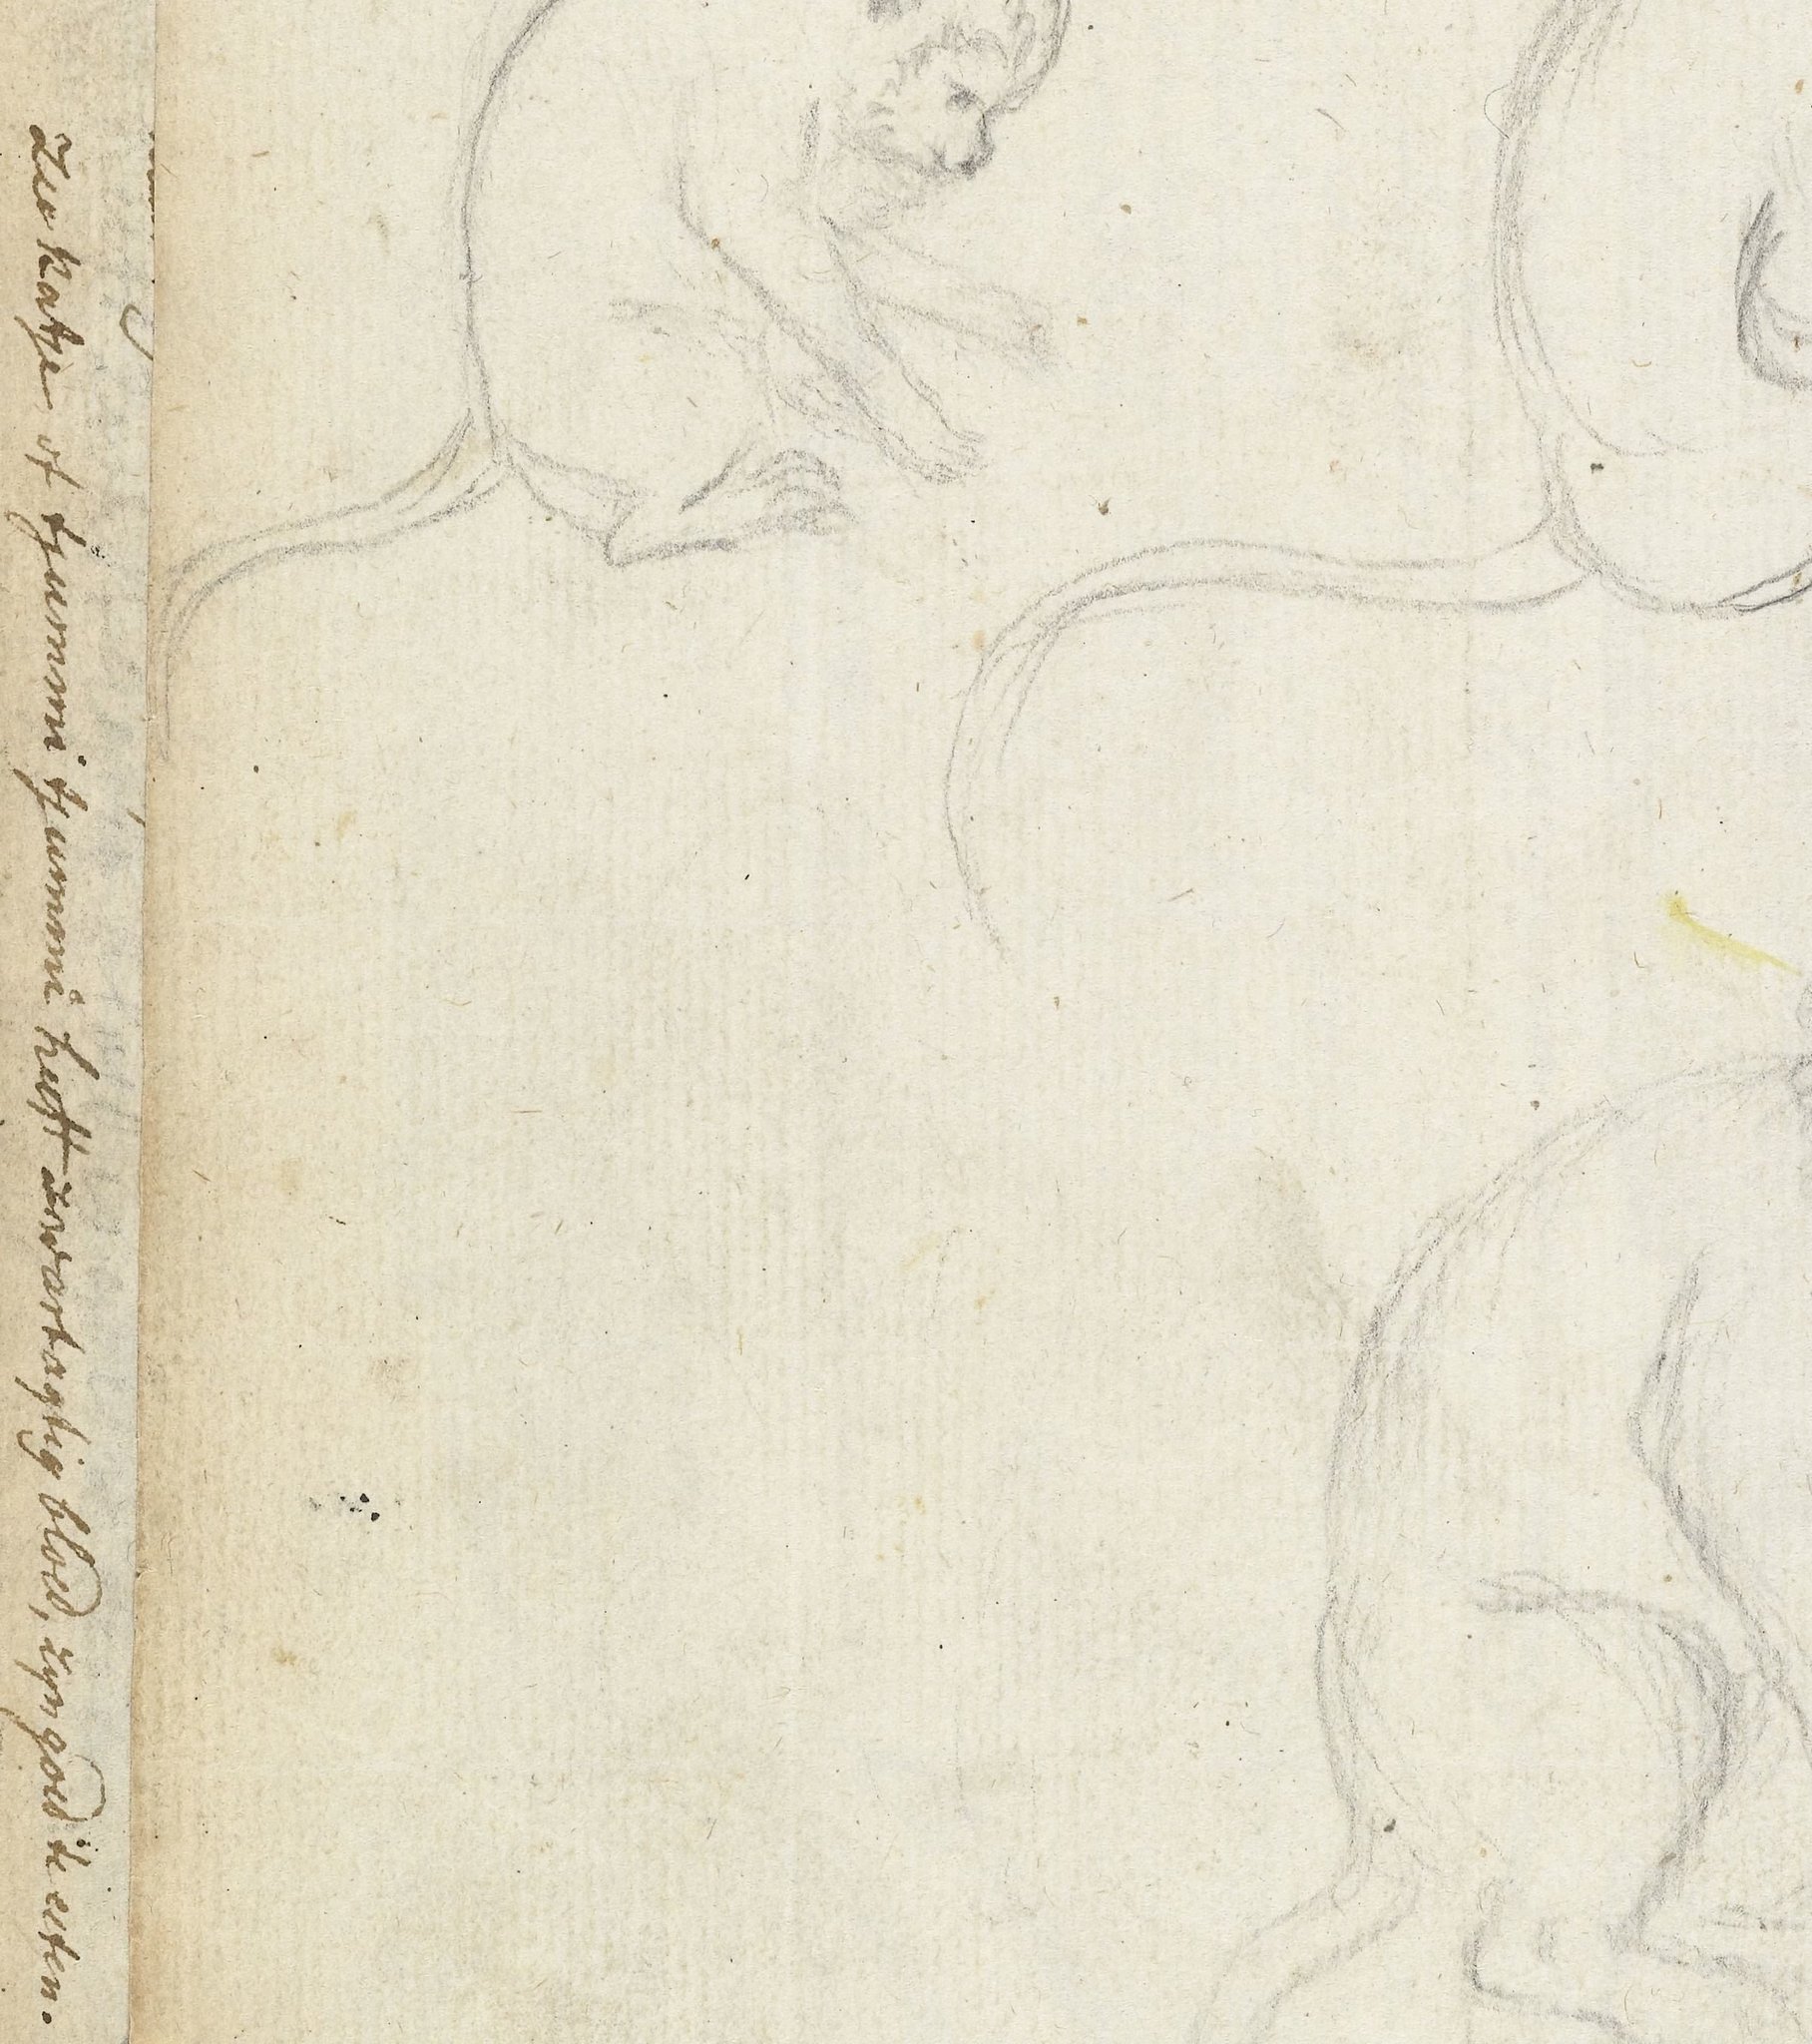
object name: drawing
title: Apen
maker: jan brandes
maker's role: draughtsman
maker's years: 1743-1808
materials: paper, pencil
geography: jakarta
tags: monkeys, apes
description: Schets van drie aapjes of telkens dezelfde aap in verschillende houdingen. Onderdeel uit het schetsboek van Jan Brandes, dl. 1 (1808), p. 238.